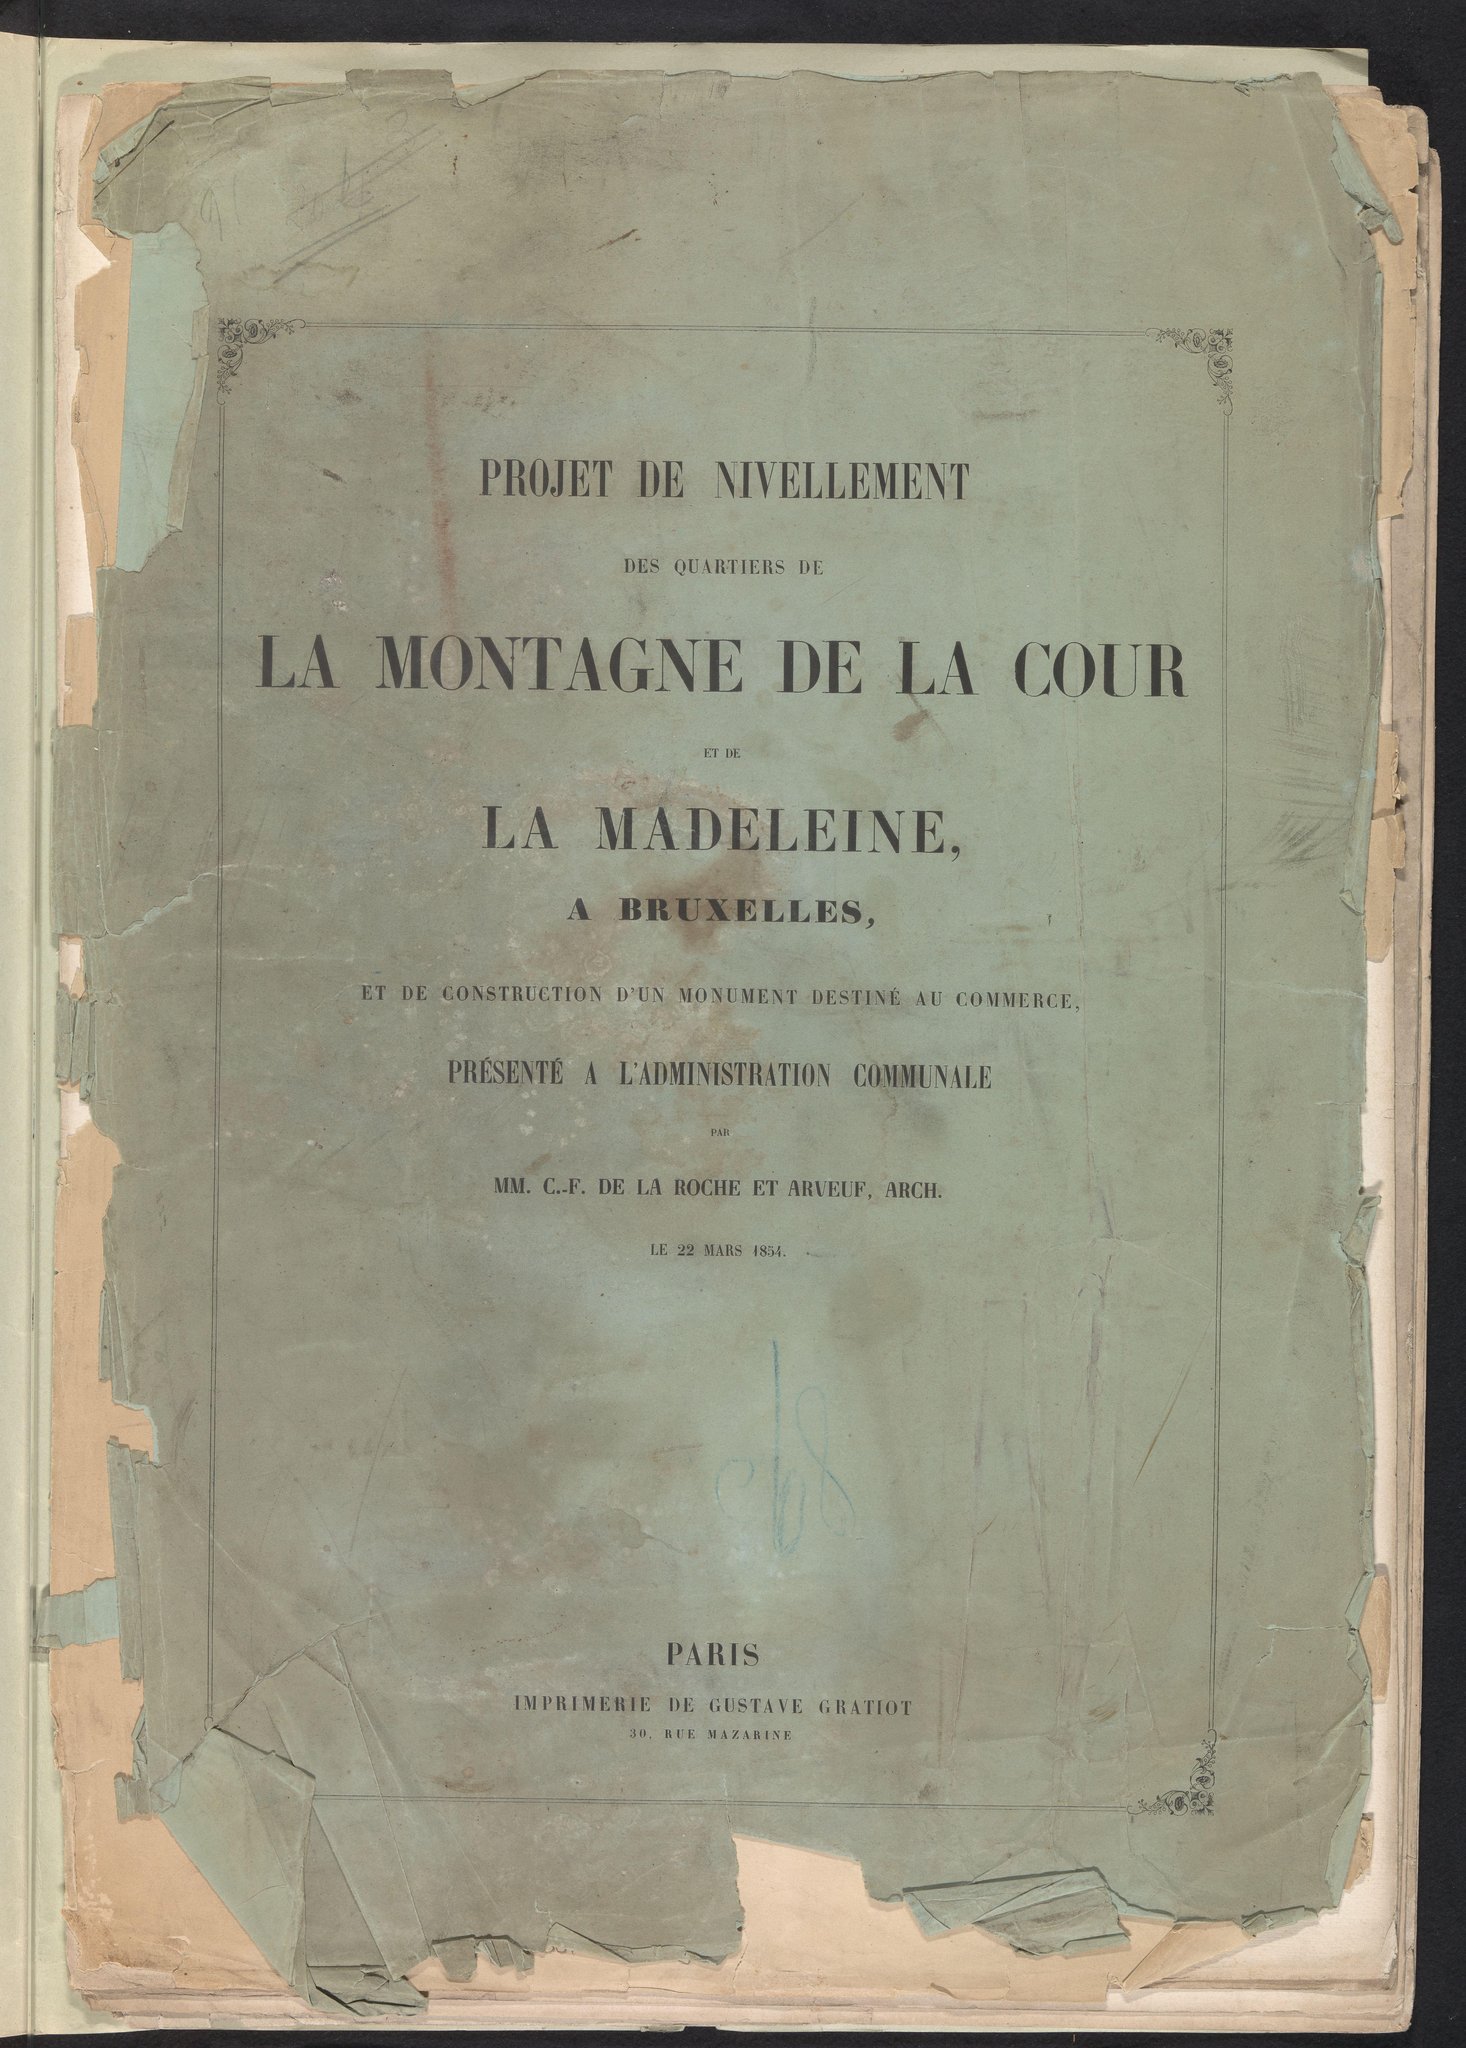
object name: magazine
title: Projet de nivellement des quartiers de la Montagne de la Cour et de la Madeleine, à Bruxelles, et de construction d'un monument destiné au commerce, présenté à l'administration communale par MM. C.-F. de la Roche et Arveuf, arch., le 22 mars 1854.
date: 1854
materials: cardboard, paper, photographic support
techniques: albumen print, lithograph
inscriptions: inscription: ‘Timbre imperial’